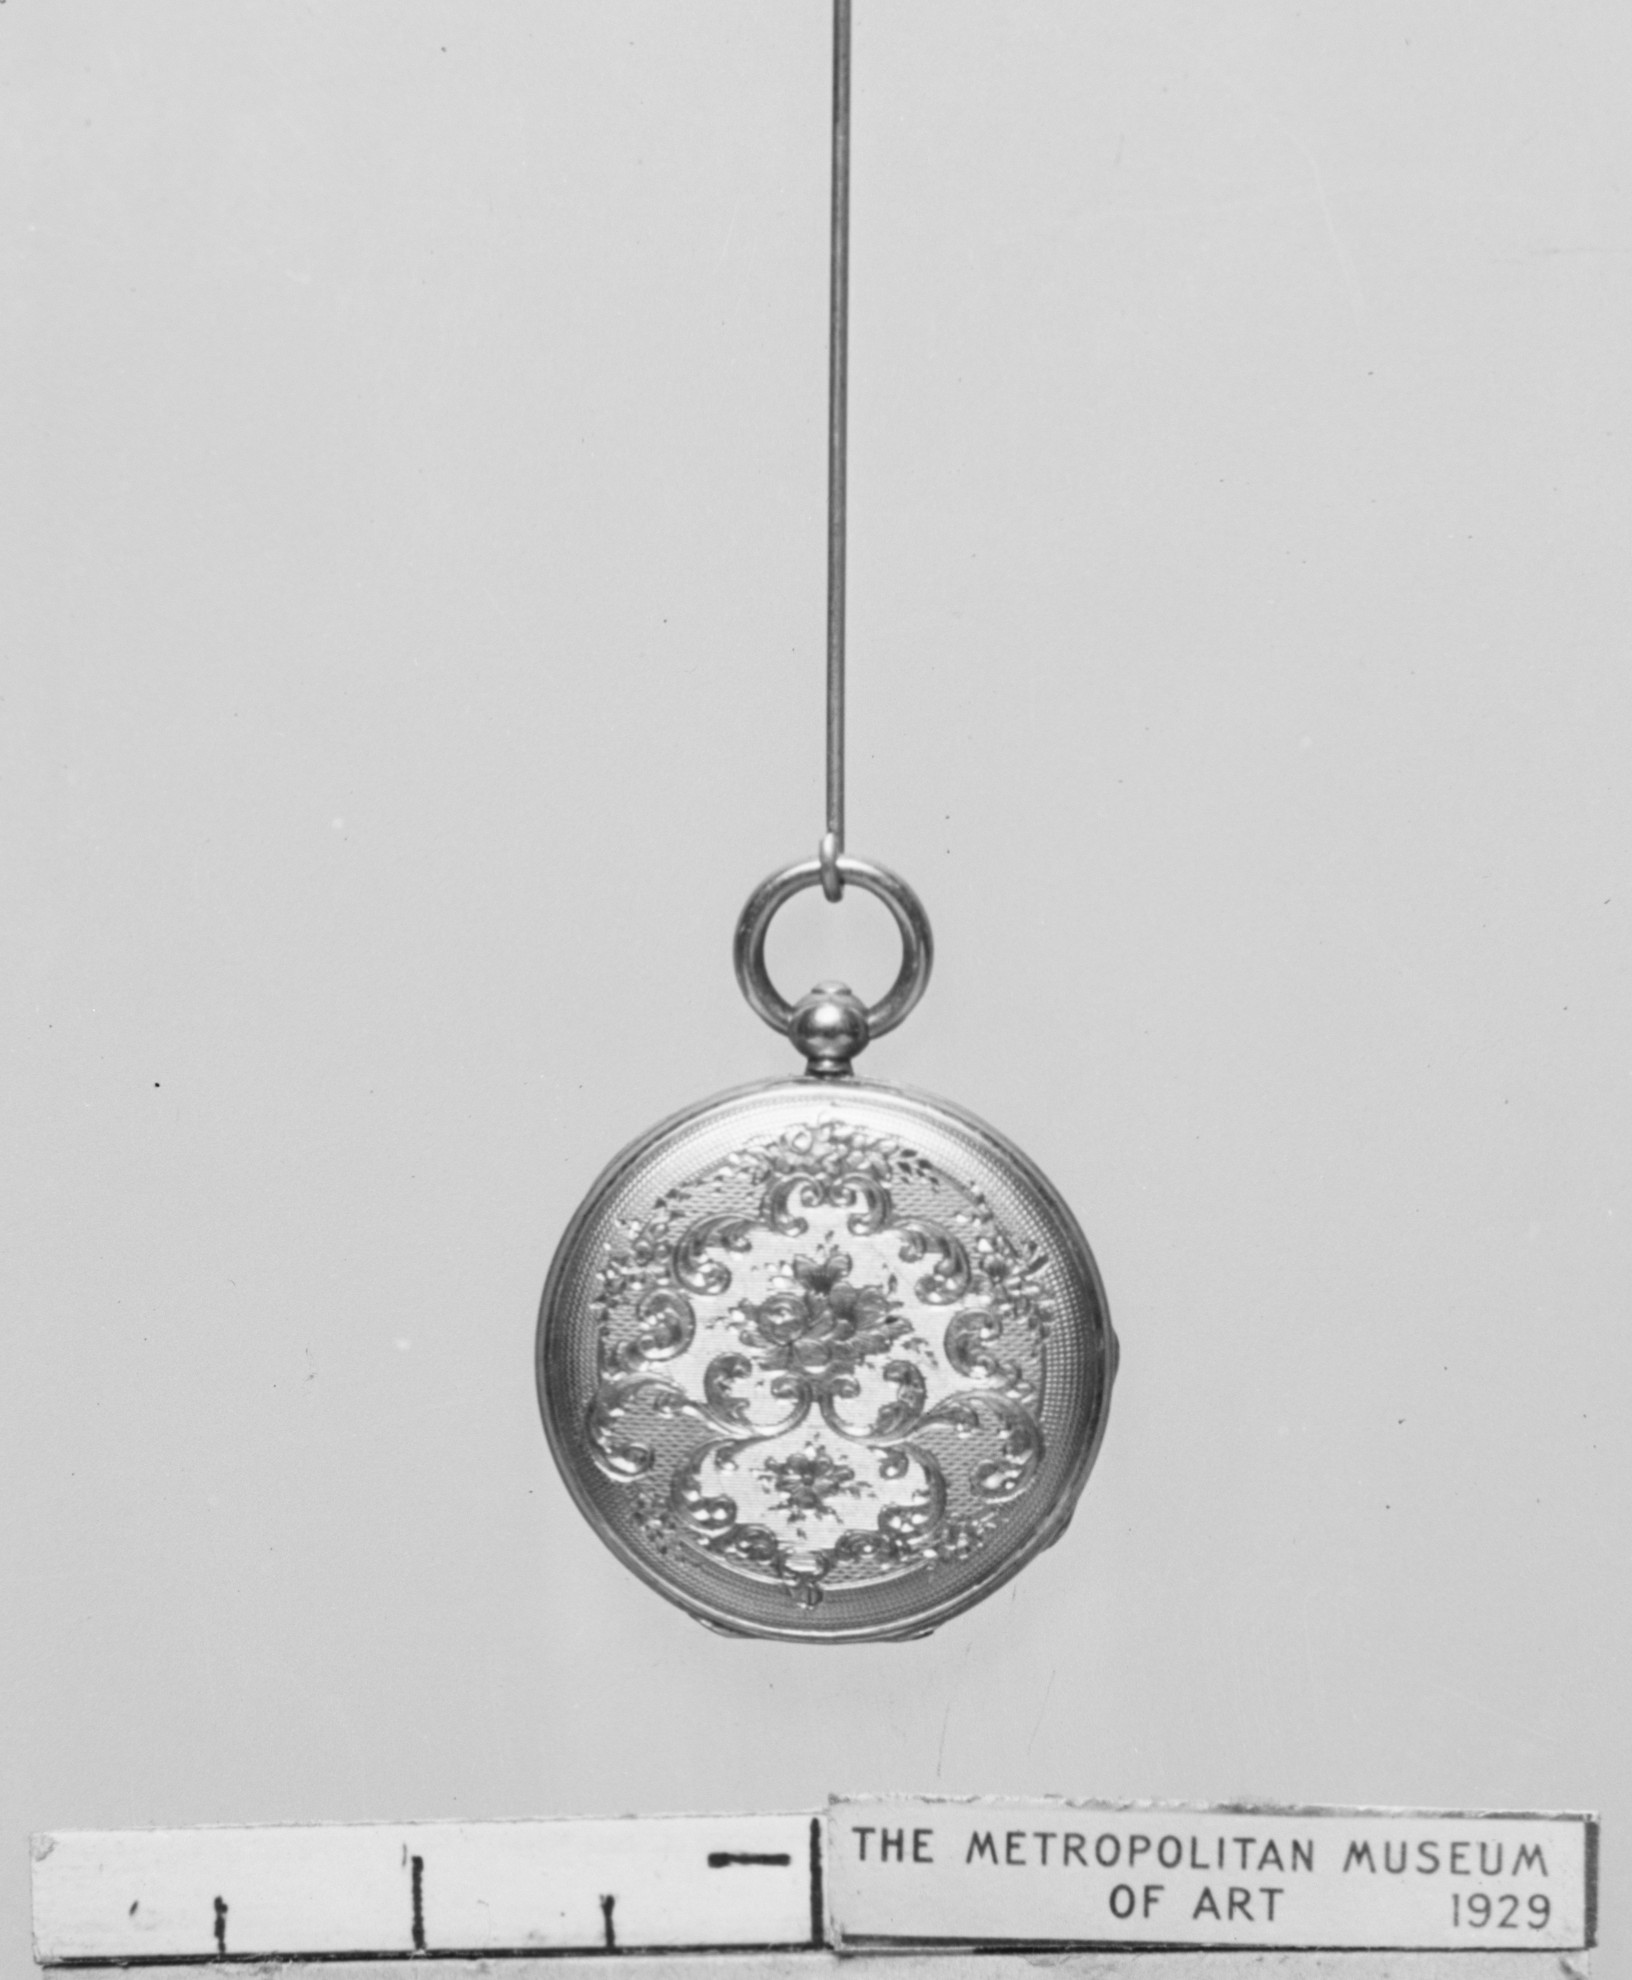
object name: watch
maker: firm of burkhardt & brandt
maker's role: maker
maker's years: 1805-1815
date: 1801-1833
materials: gold, silver